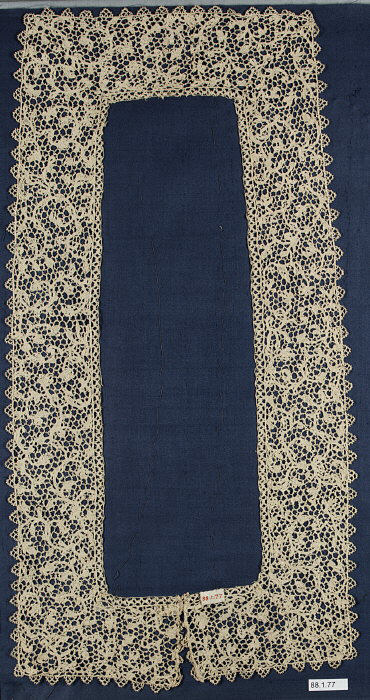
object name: border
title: Shaped border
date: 1701-1800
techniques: lace